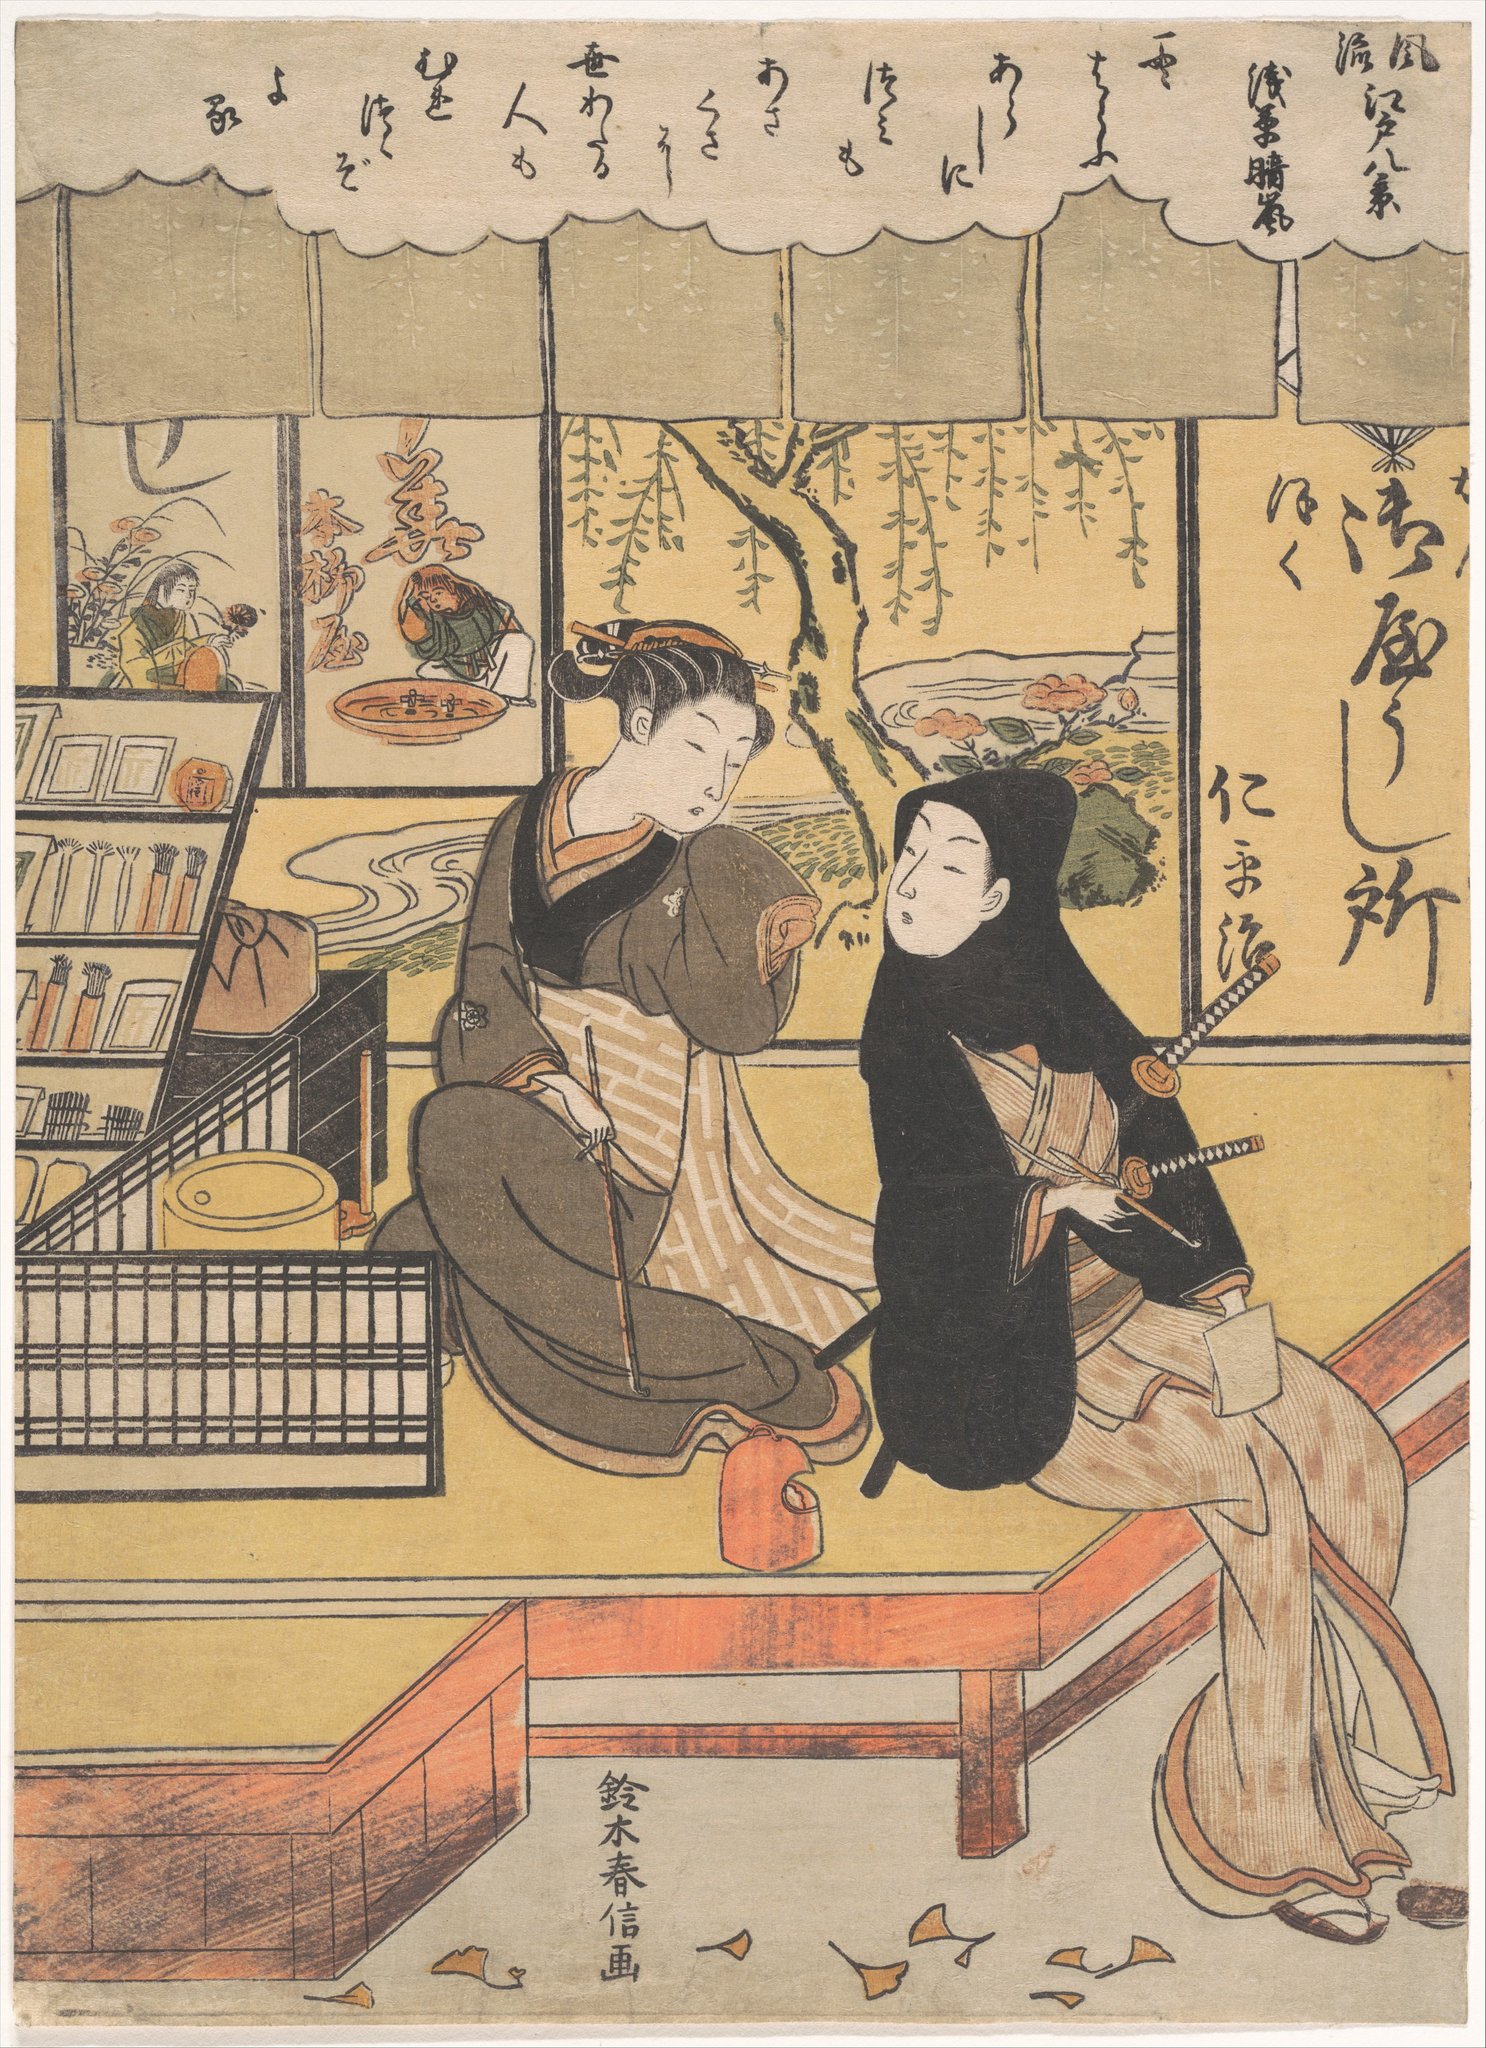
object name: print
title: Asakusa Seiran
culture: japanese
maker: suzuki harunobu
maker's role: artist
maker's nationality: japanese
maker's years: 1725-1770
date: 1725-1770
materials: ink, paper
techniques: woodblock print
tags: swords,men,women,pipes